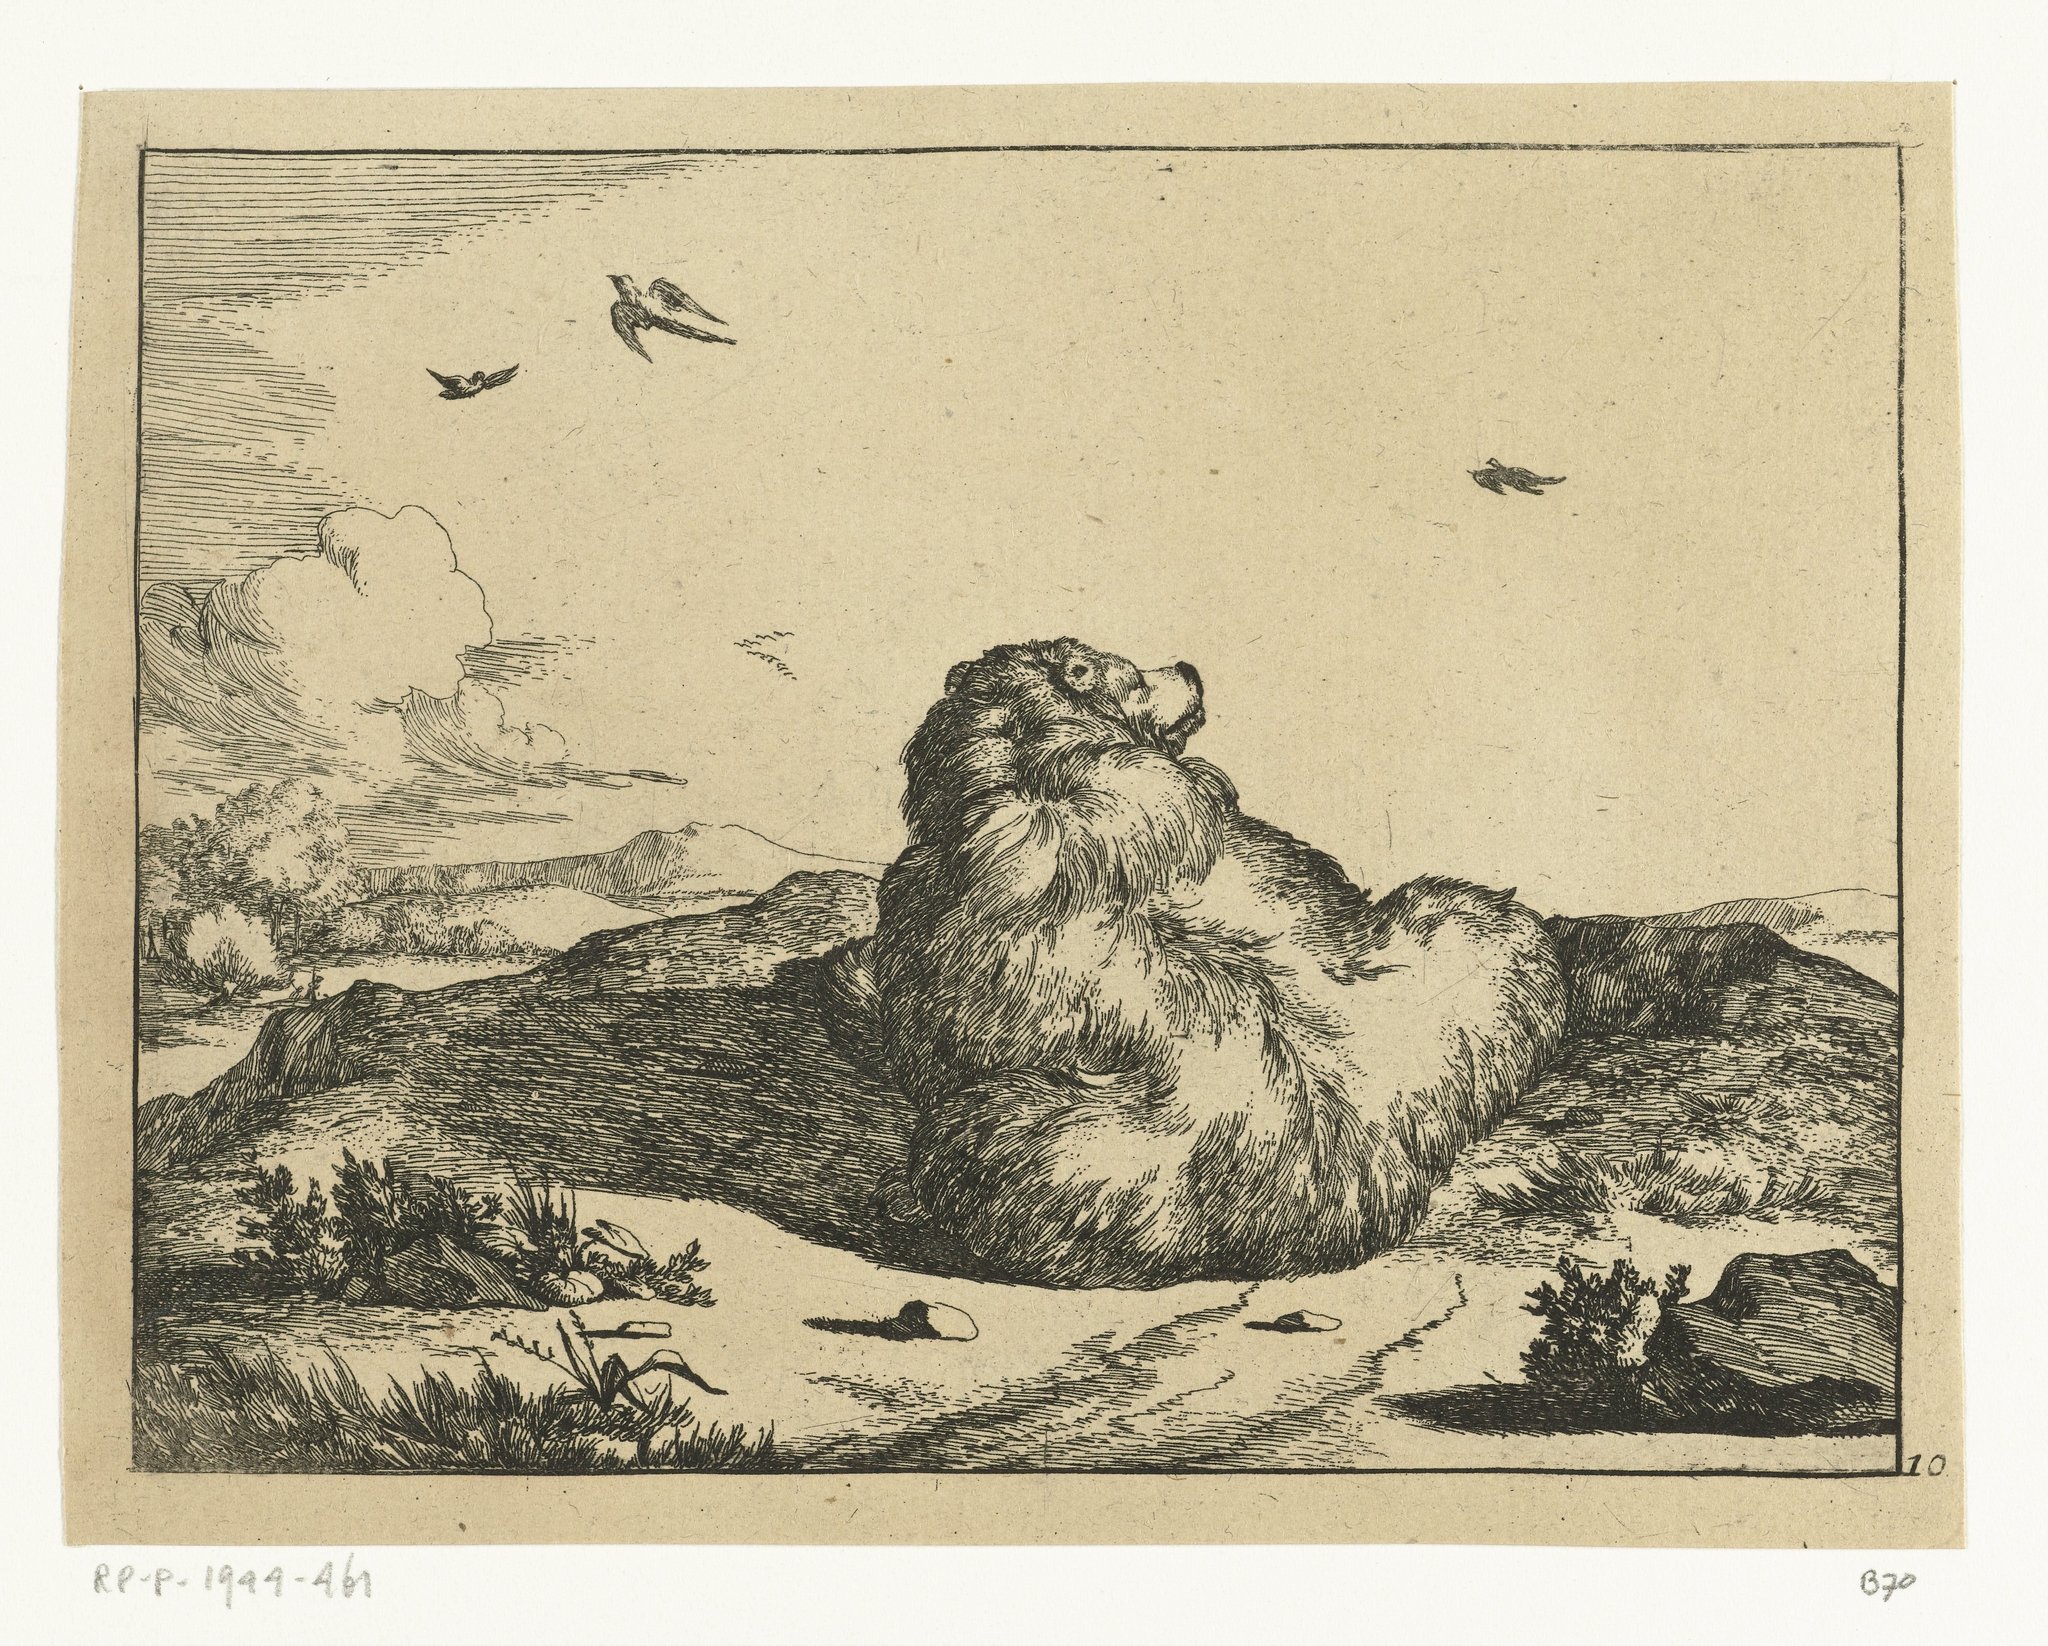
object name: print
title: Beren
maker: marcus de bye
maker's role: print maker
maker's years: 1639-1688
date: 1664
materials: paper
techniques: etching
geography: the hague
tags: beasts of prey, predatory animals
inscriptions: collector's mark: Lugt 2228